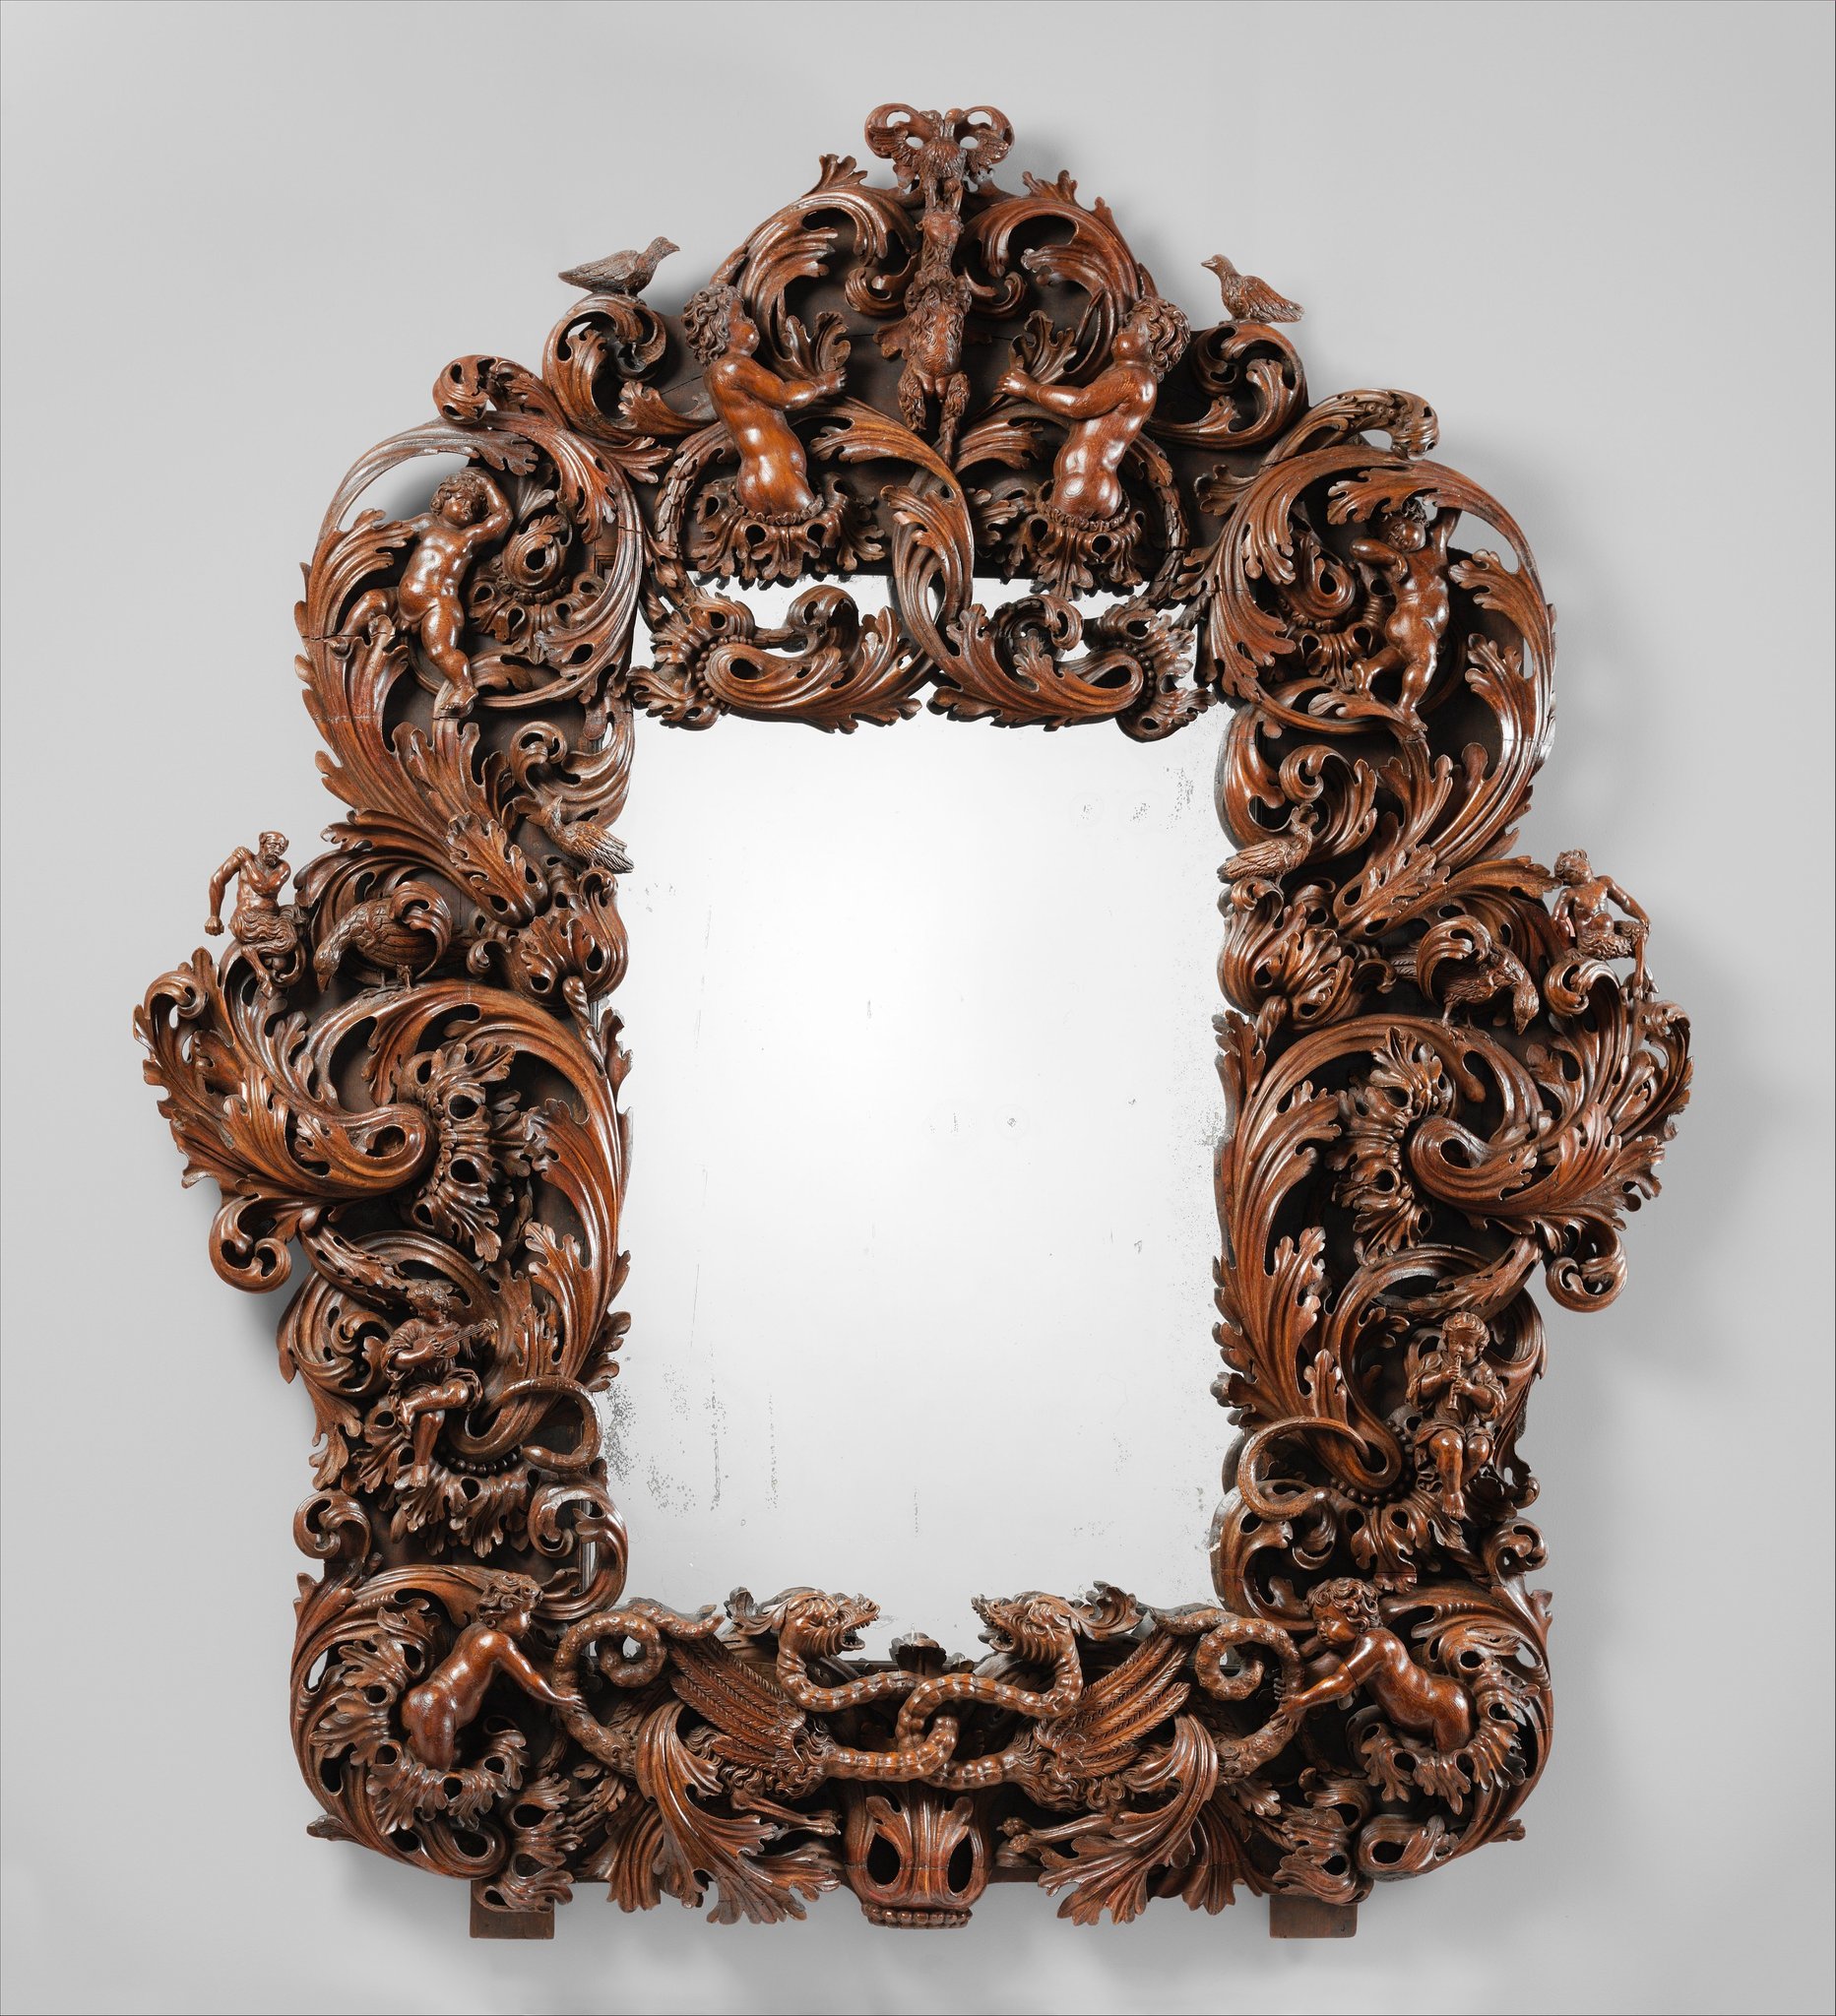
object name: mirror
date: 1680-1700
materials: glass, wood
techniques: stain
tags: birds,dragons,putti